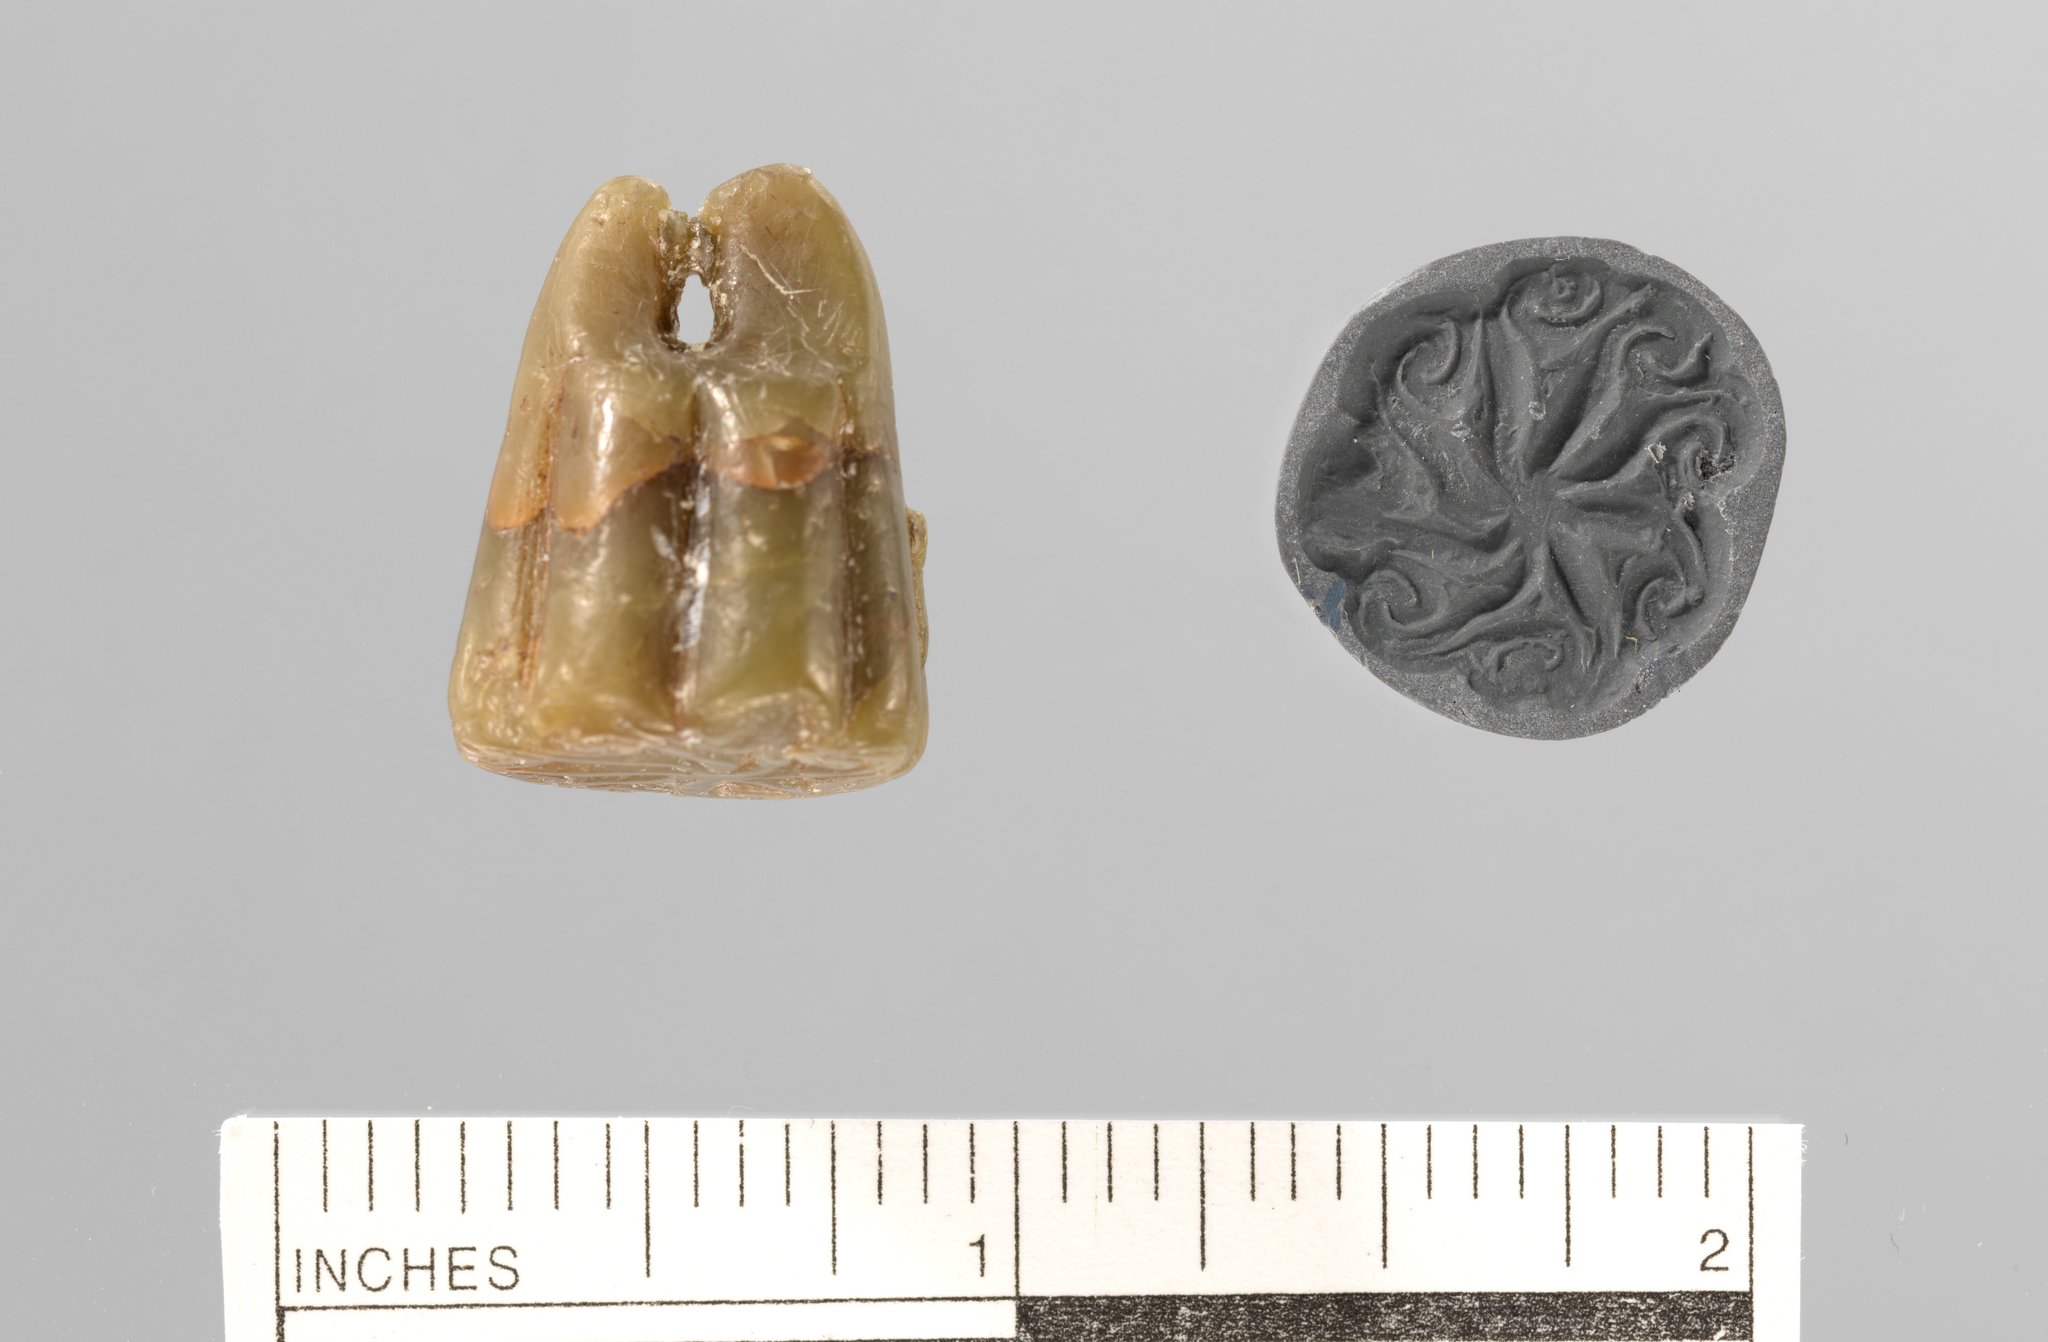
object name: stamp seal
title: Steatite Stamp Seal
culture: minoan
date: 1900-1700 BCE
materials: stone